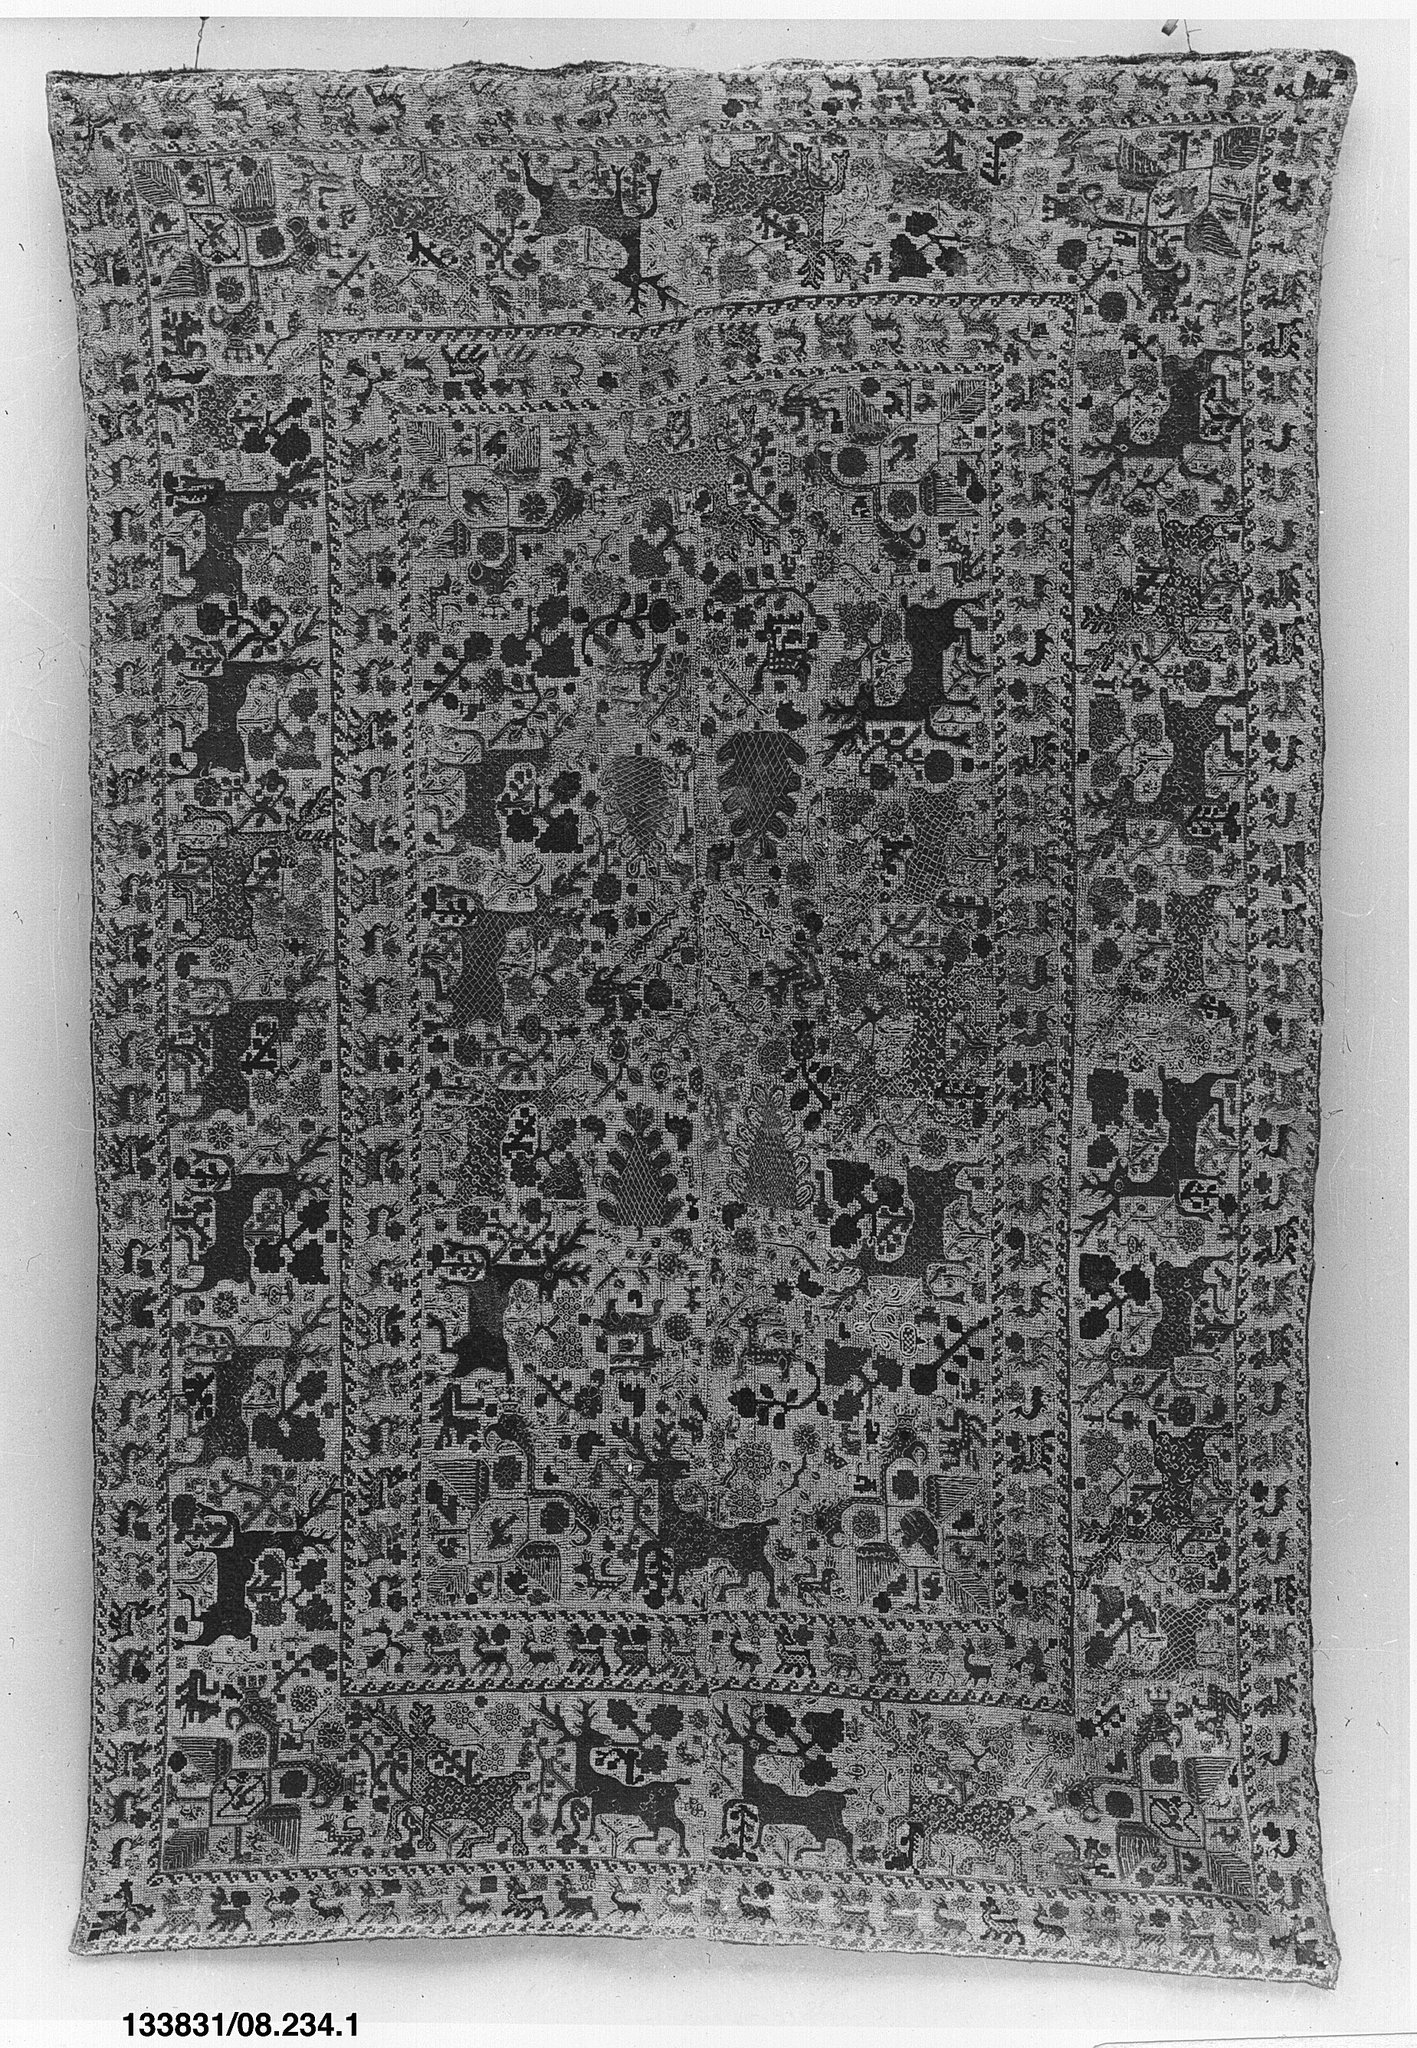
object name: rug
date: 1550-1600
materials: cotton, linen, wool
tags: deer